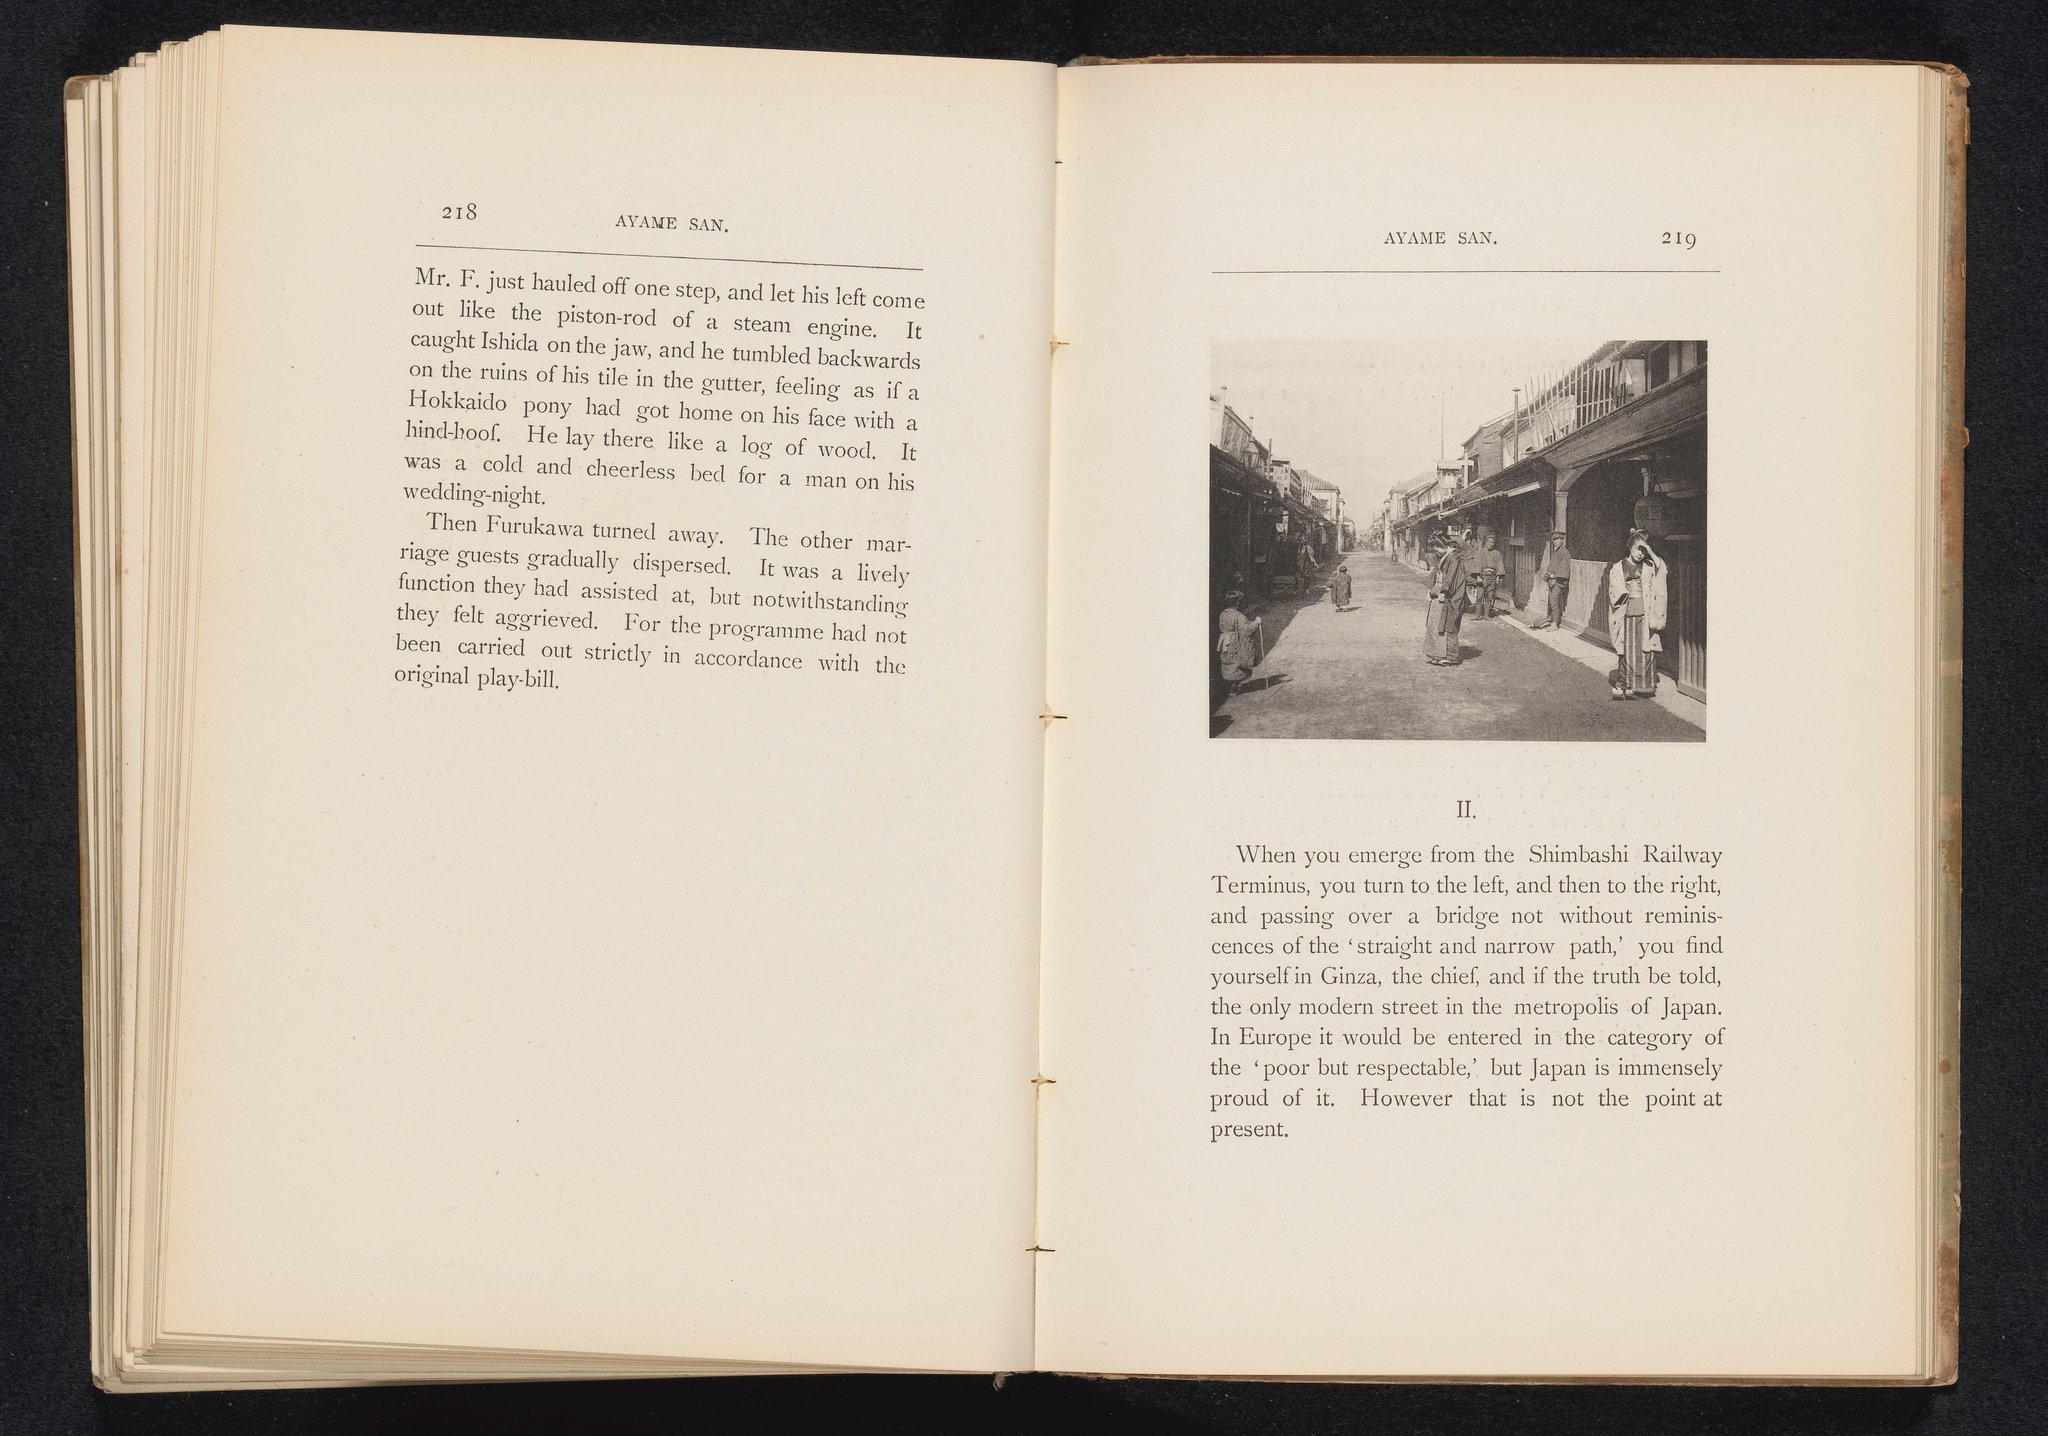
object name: photomechanical print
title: Gezicht op (vermoedelijk) een straat in de wijk Ginza te Tokyo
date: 1882-1892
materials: paper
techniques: photograph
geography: japan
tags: street